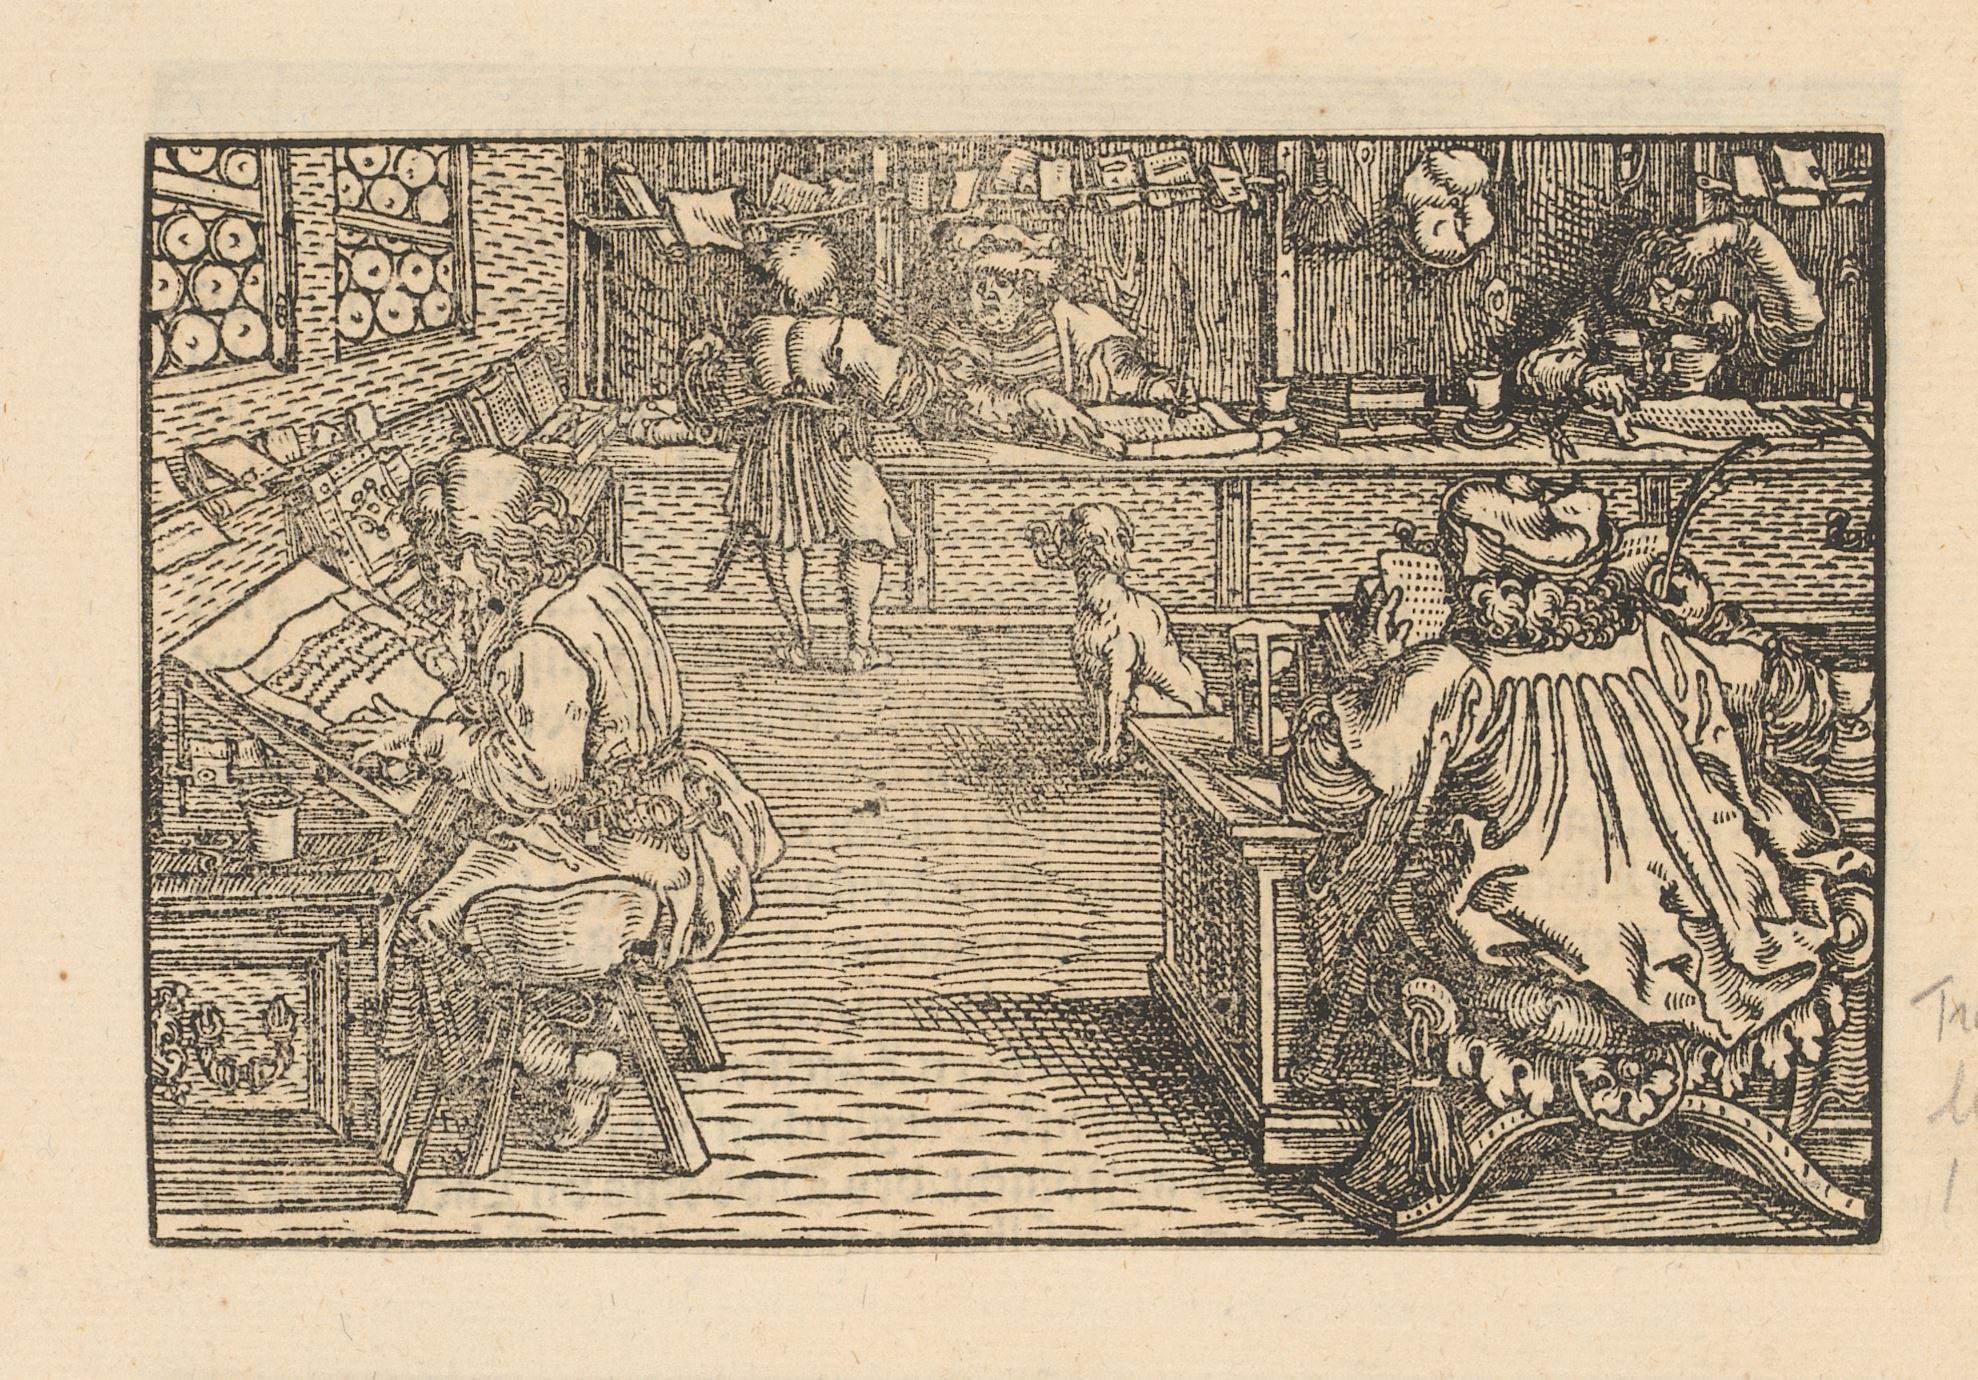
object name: book illustration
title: Mannen lezen in een bibliotheek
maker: Anonymous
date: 1514-1532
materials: paper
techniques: letterpress printing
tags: study; 'studiolo'; library, public library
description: Deze prent is gebruikt in: Petrarca, Francesco. Von der Artzney bayder Glück, des guten und widerwertigen: unnd weß sich ain yeder inn Gelück und Unglück halten sol (...). Augsburg: Heinrich Steiner, 1532. Deze uitgave is ook bekend onder de titel 'Trostspiegel in Glück und Unglück'.